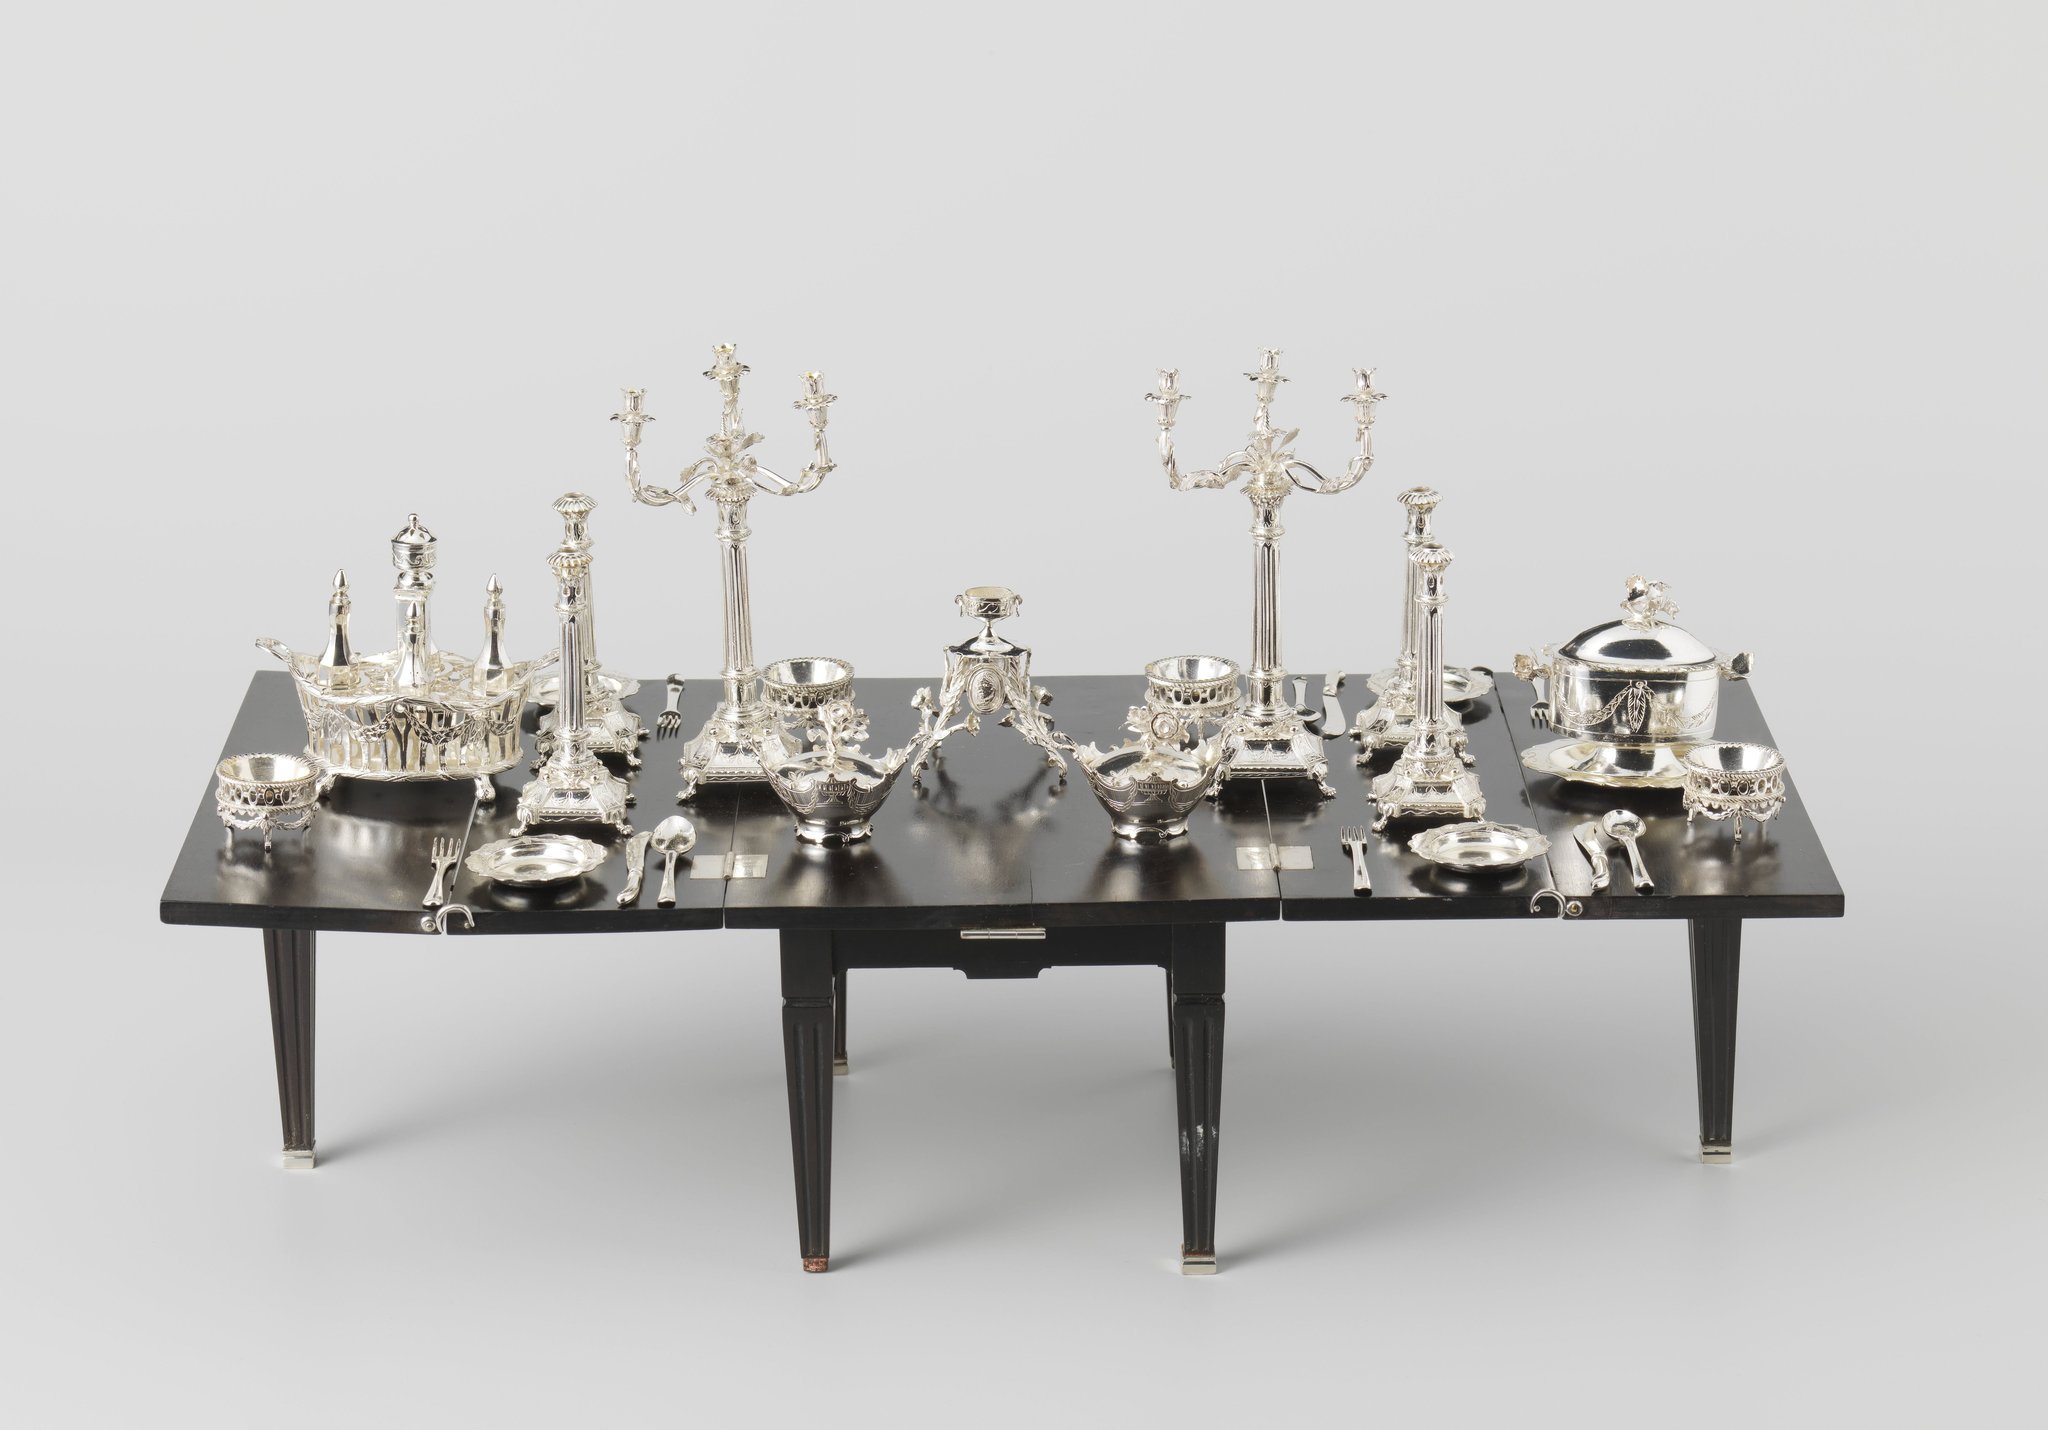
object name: miniature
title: Bord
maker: Anonymous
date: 1782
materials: silver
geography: amsterdam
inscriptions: maker's mark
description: Rond eetbord met geschulpte rand. Op de rand zijn guirlandes gegraveerd.In het midden van het bord is een bloem gegraveerd. Het bord is gemerkt: stk.= Amsterdam, jrl.= X (1782) en mt.= Voet 430. Het bord is een exemplaar van een set bestaande uit 36 identieke borden (BK-NM-11177-189 t/m BK-NM-11177-224).